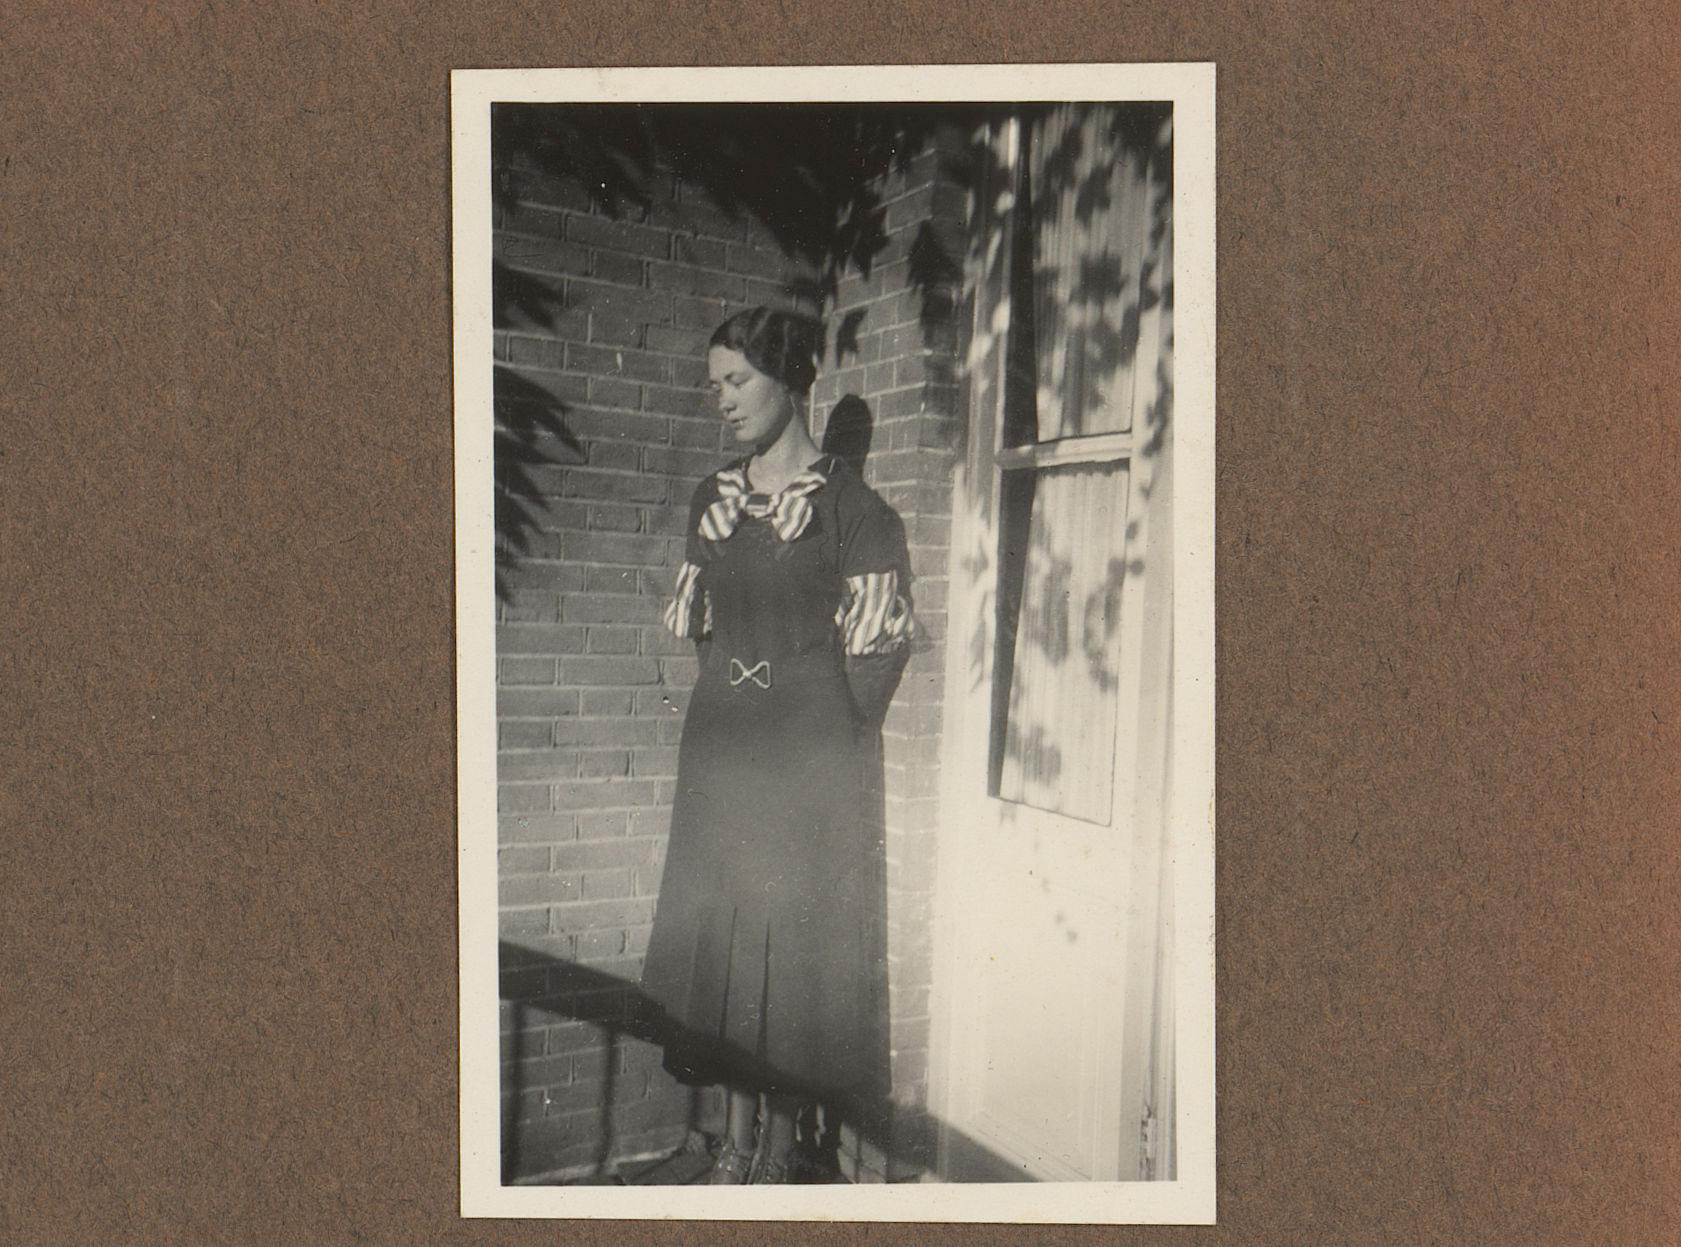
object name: photograph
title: Jonge vrouw voor muur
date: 1900-1920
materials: photographic support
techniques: photography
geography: netherlands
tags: netherlands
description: Foto op bruin albumblad 55 van familiealbum van Alphons Diepenbrock.